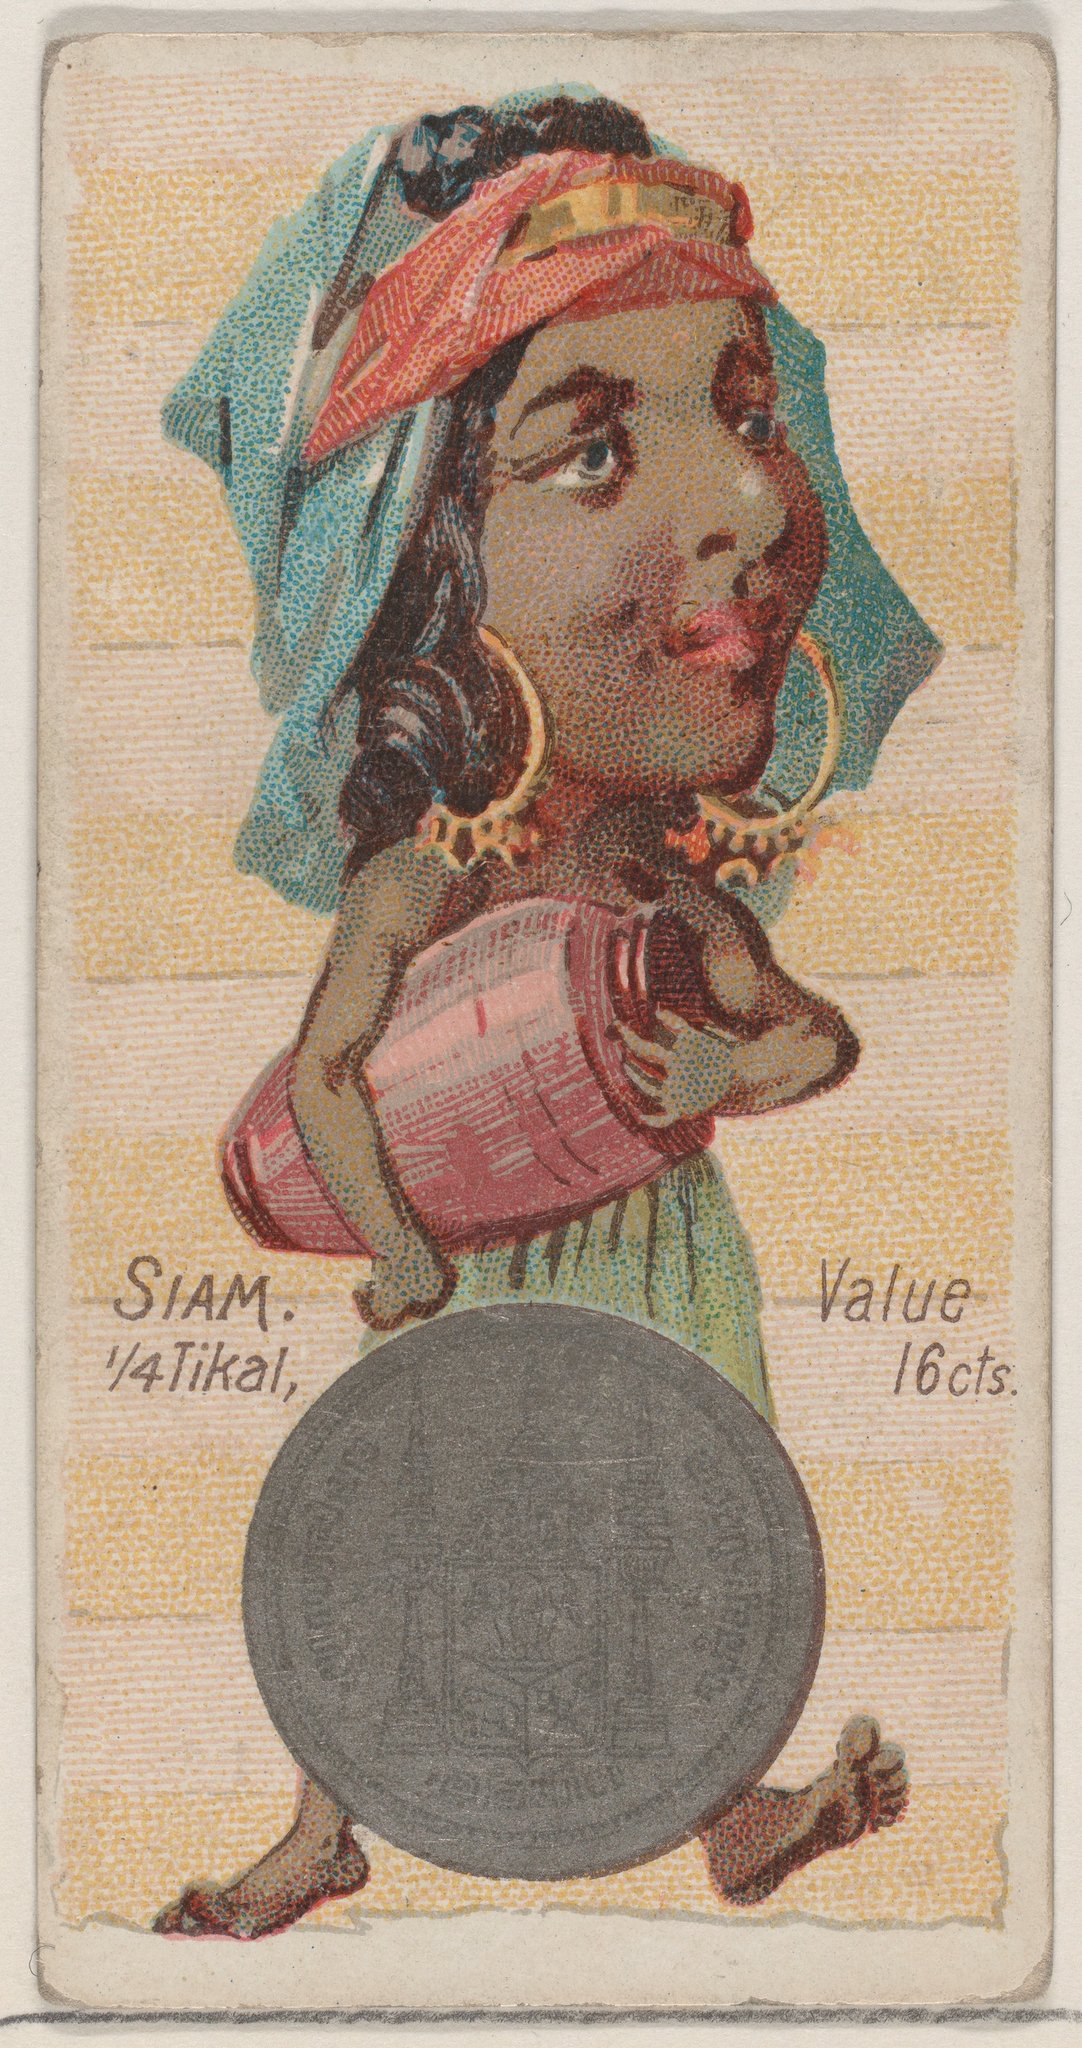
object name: print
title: Caricatured figure from Siam, 1/4 Tikal, from the series Coins of All Nations (N72, variation 2) for Duke brand cigarettes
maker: w. duke, sons & co.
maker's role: publisher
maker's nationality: american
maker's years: 1870-1920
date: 1889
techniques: color lithograph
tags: coins